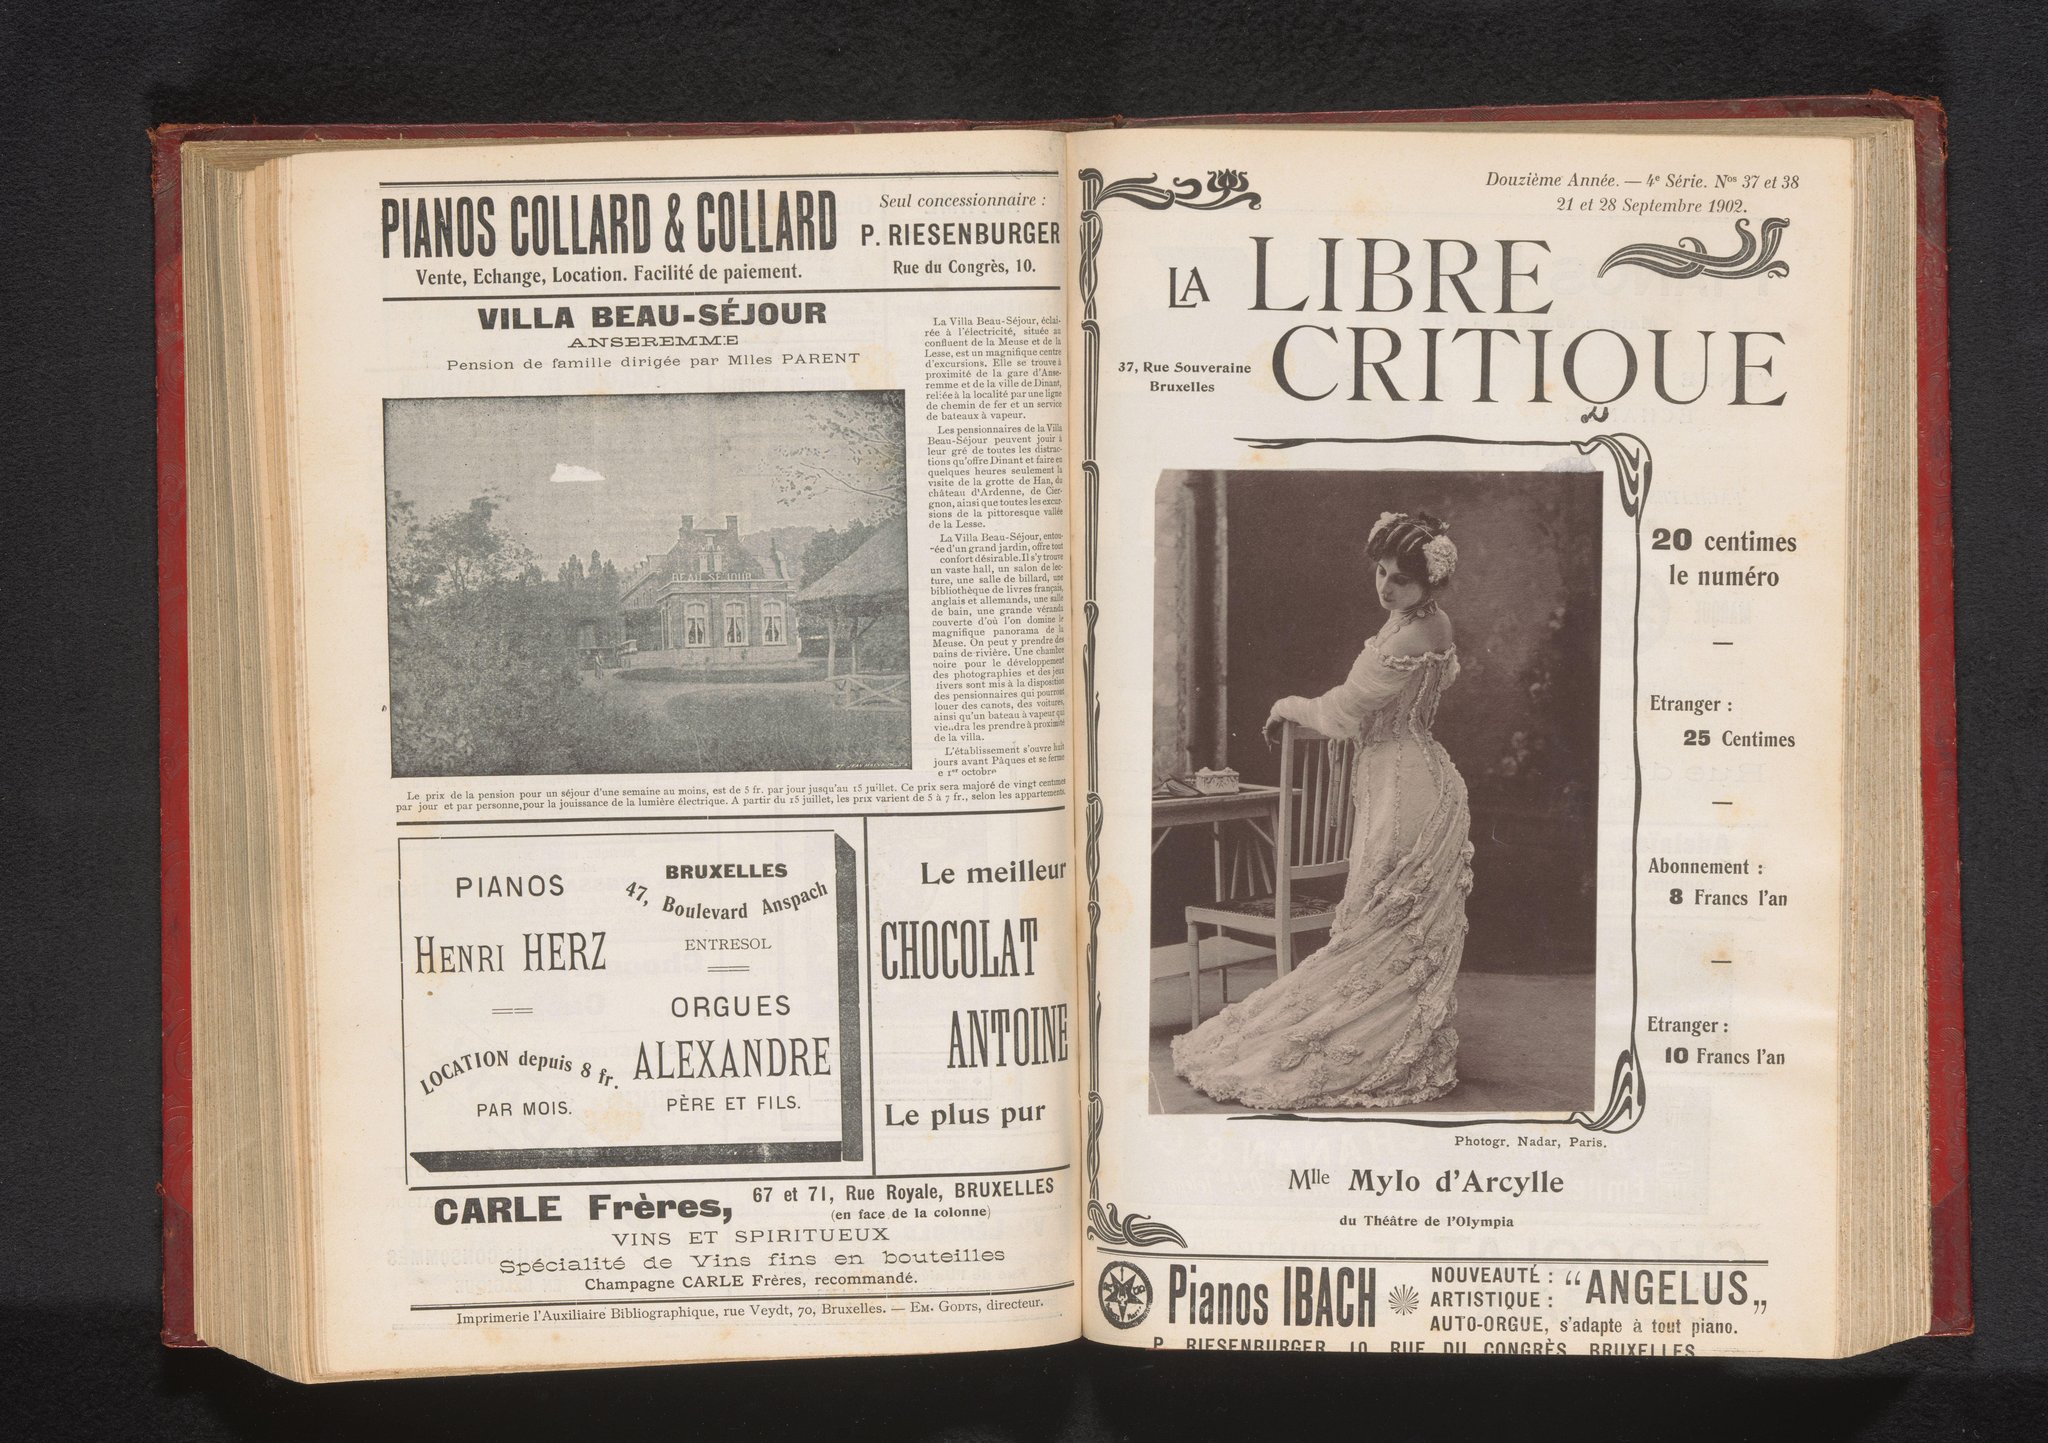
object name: page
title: Mlle Mylo d'Arcylle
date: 1897-1902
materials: paper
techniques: photograph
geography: paris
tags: portrait of actor, actress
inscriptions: inscription: ‘du Théâtre de l'Olympia’